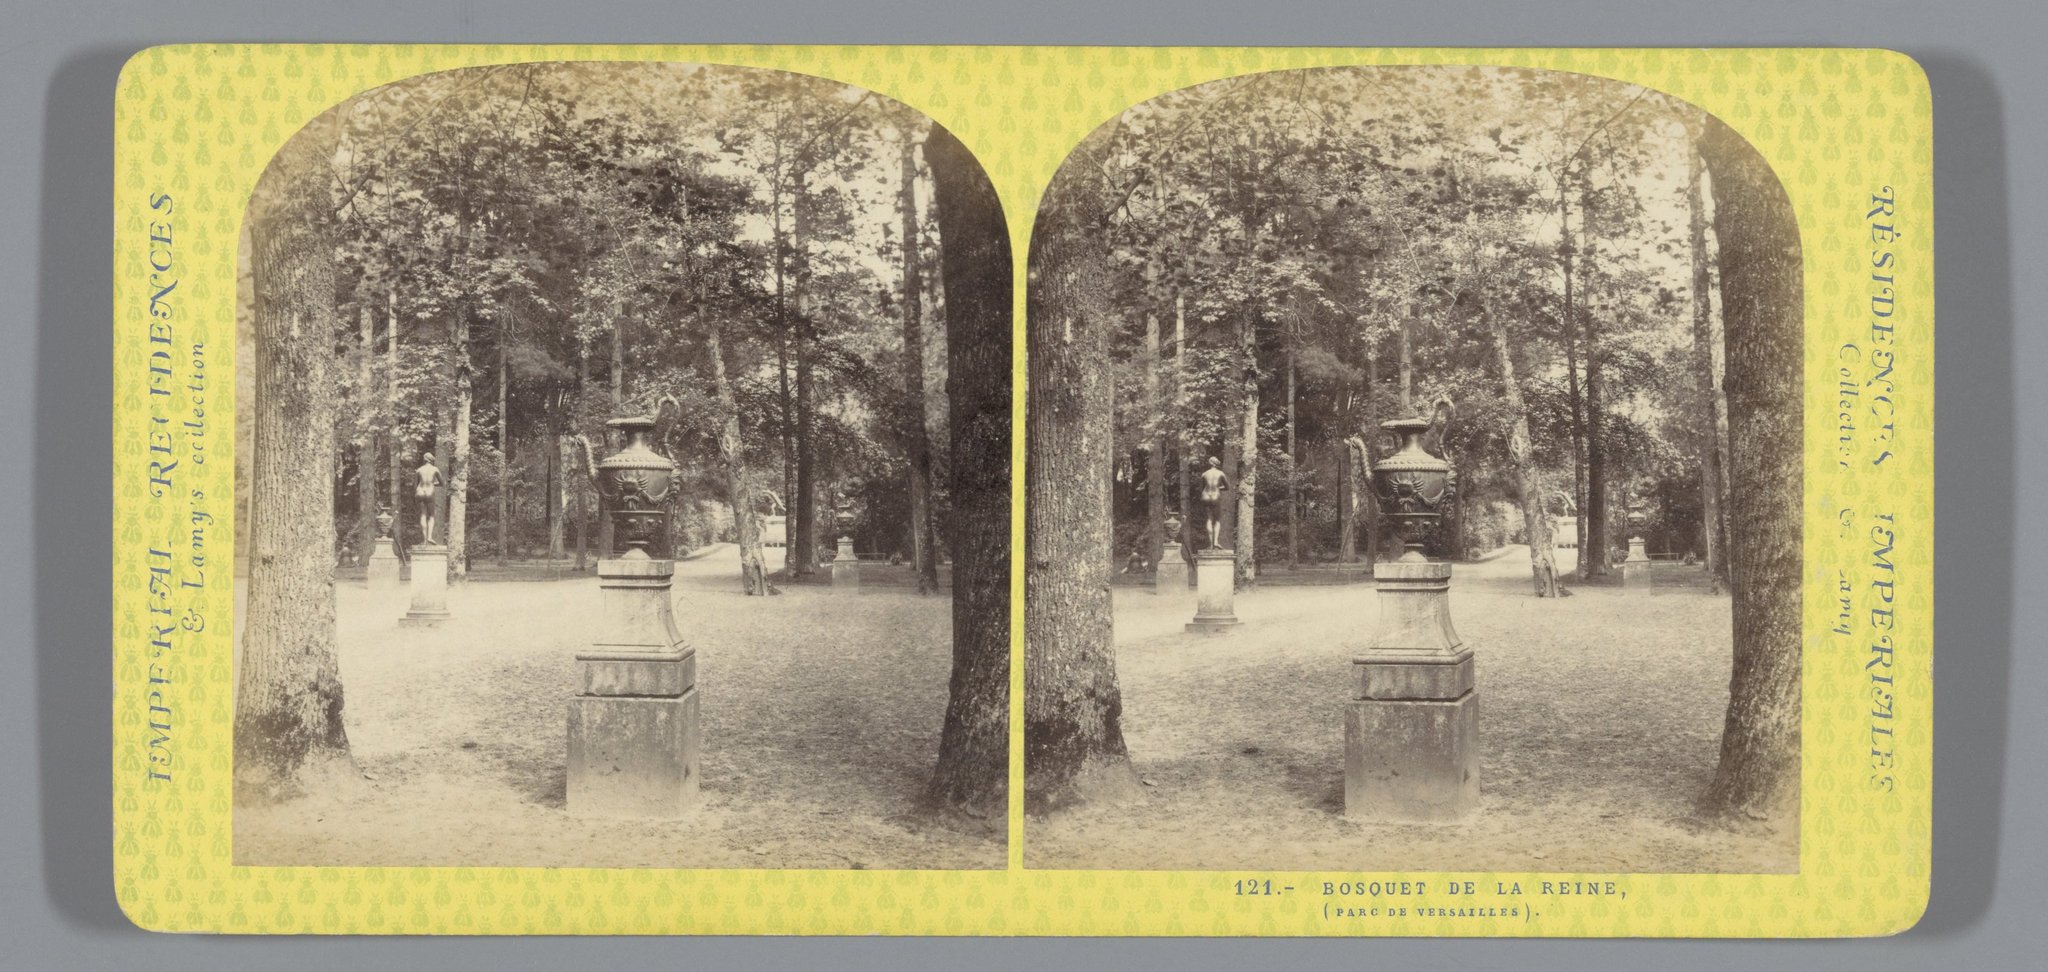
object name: stereograph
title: Vaas op een voetstuk in de tuin van Versailles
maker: ernest eléonor pierre lamy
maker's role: publisher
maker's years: 1828-1900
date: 1860-1880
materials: cardboard, photographic support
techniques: albumen print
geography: gardens of versailles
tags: garden vase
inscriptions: number: ‘121.’, inscription: ‘E. Lamy's collection’